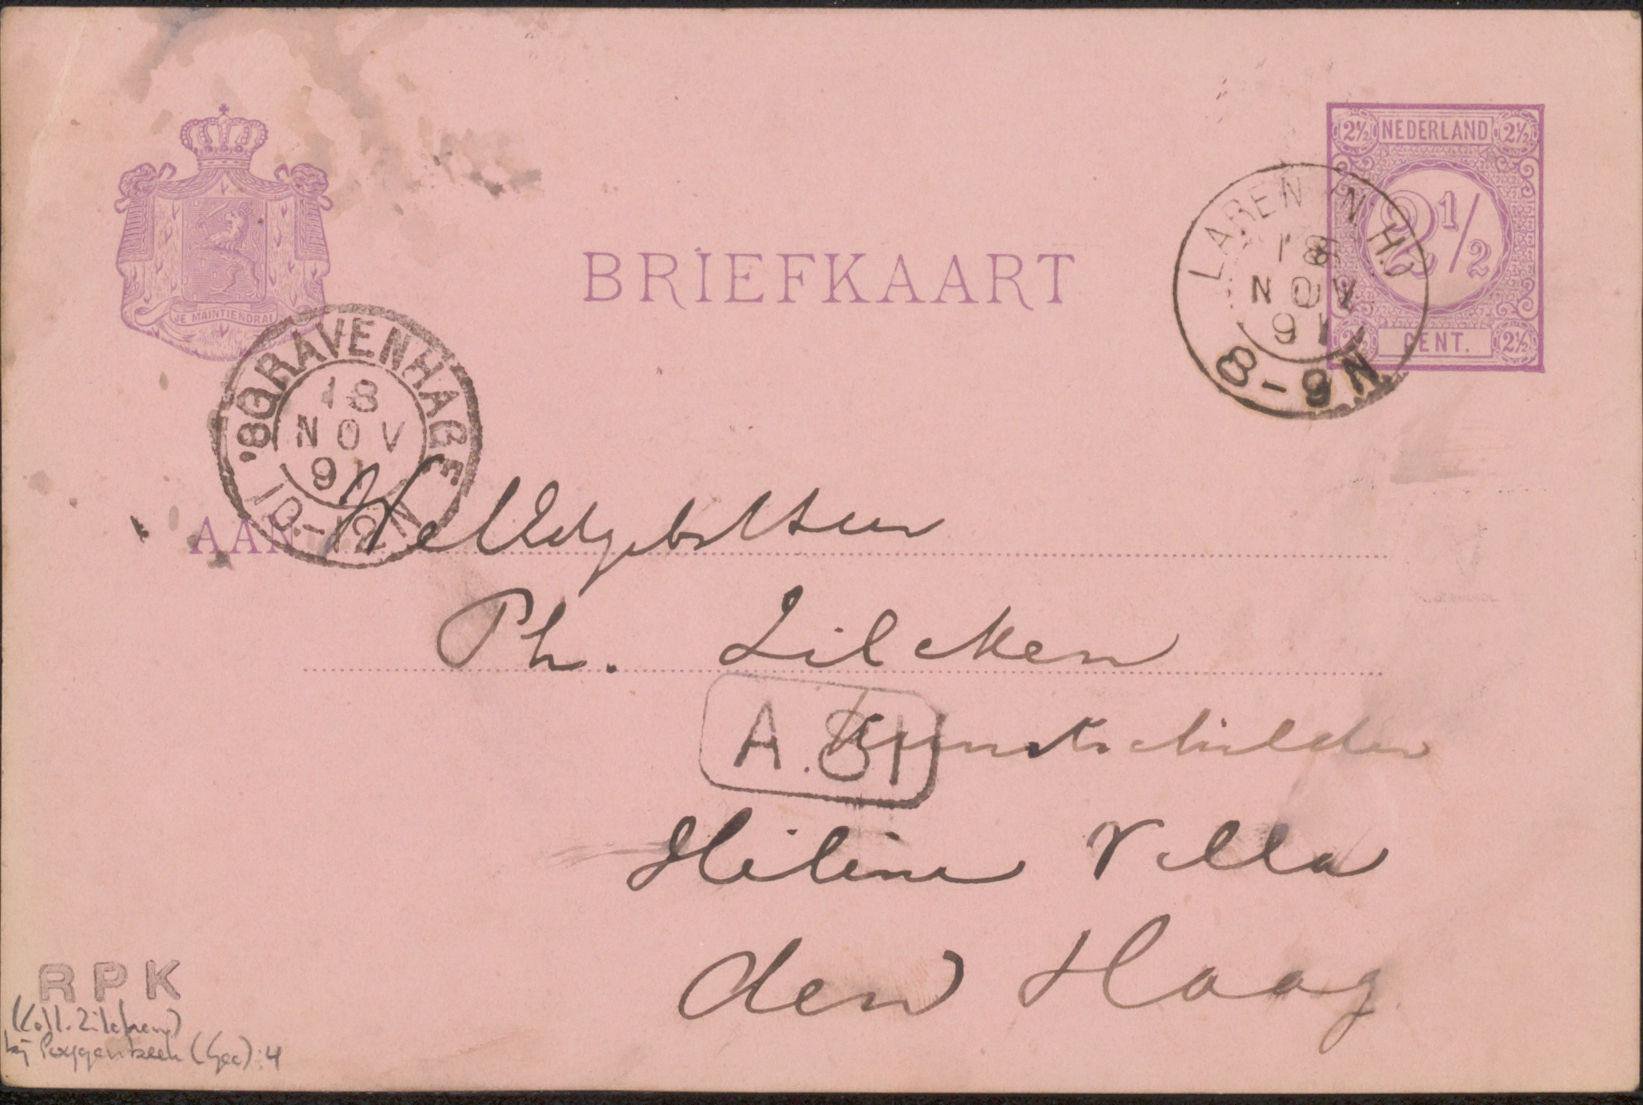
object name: postcard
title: Briefkaart aan Philip Zilcken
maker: geo poggenbeek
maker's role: draughtsman, painter, print maker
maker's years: 1853-1903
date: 1891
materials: cardboard, ink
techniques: pen, writing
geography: laren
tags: the hague, philip zilcken, money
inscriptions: collector's mark: ‘RPK’